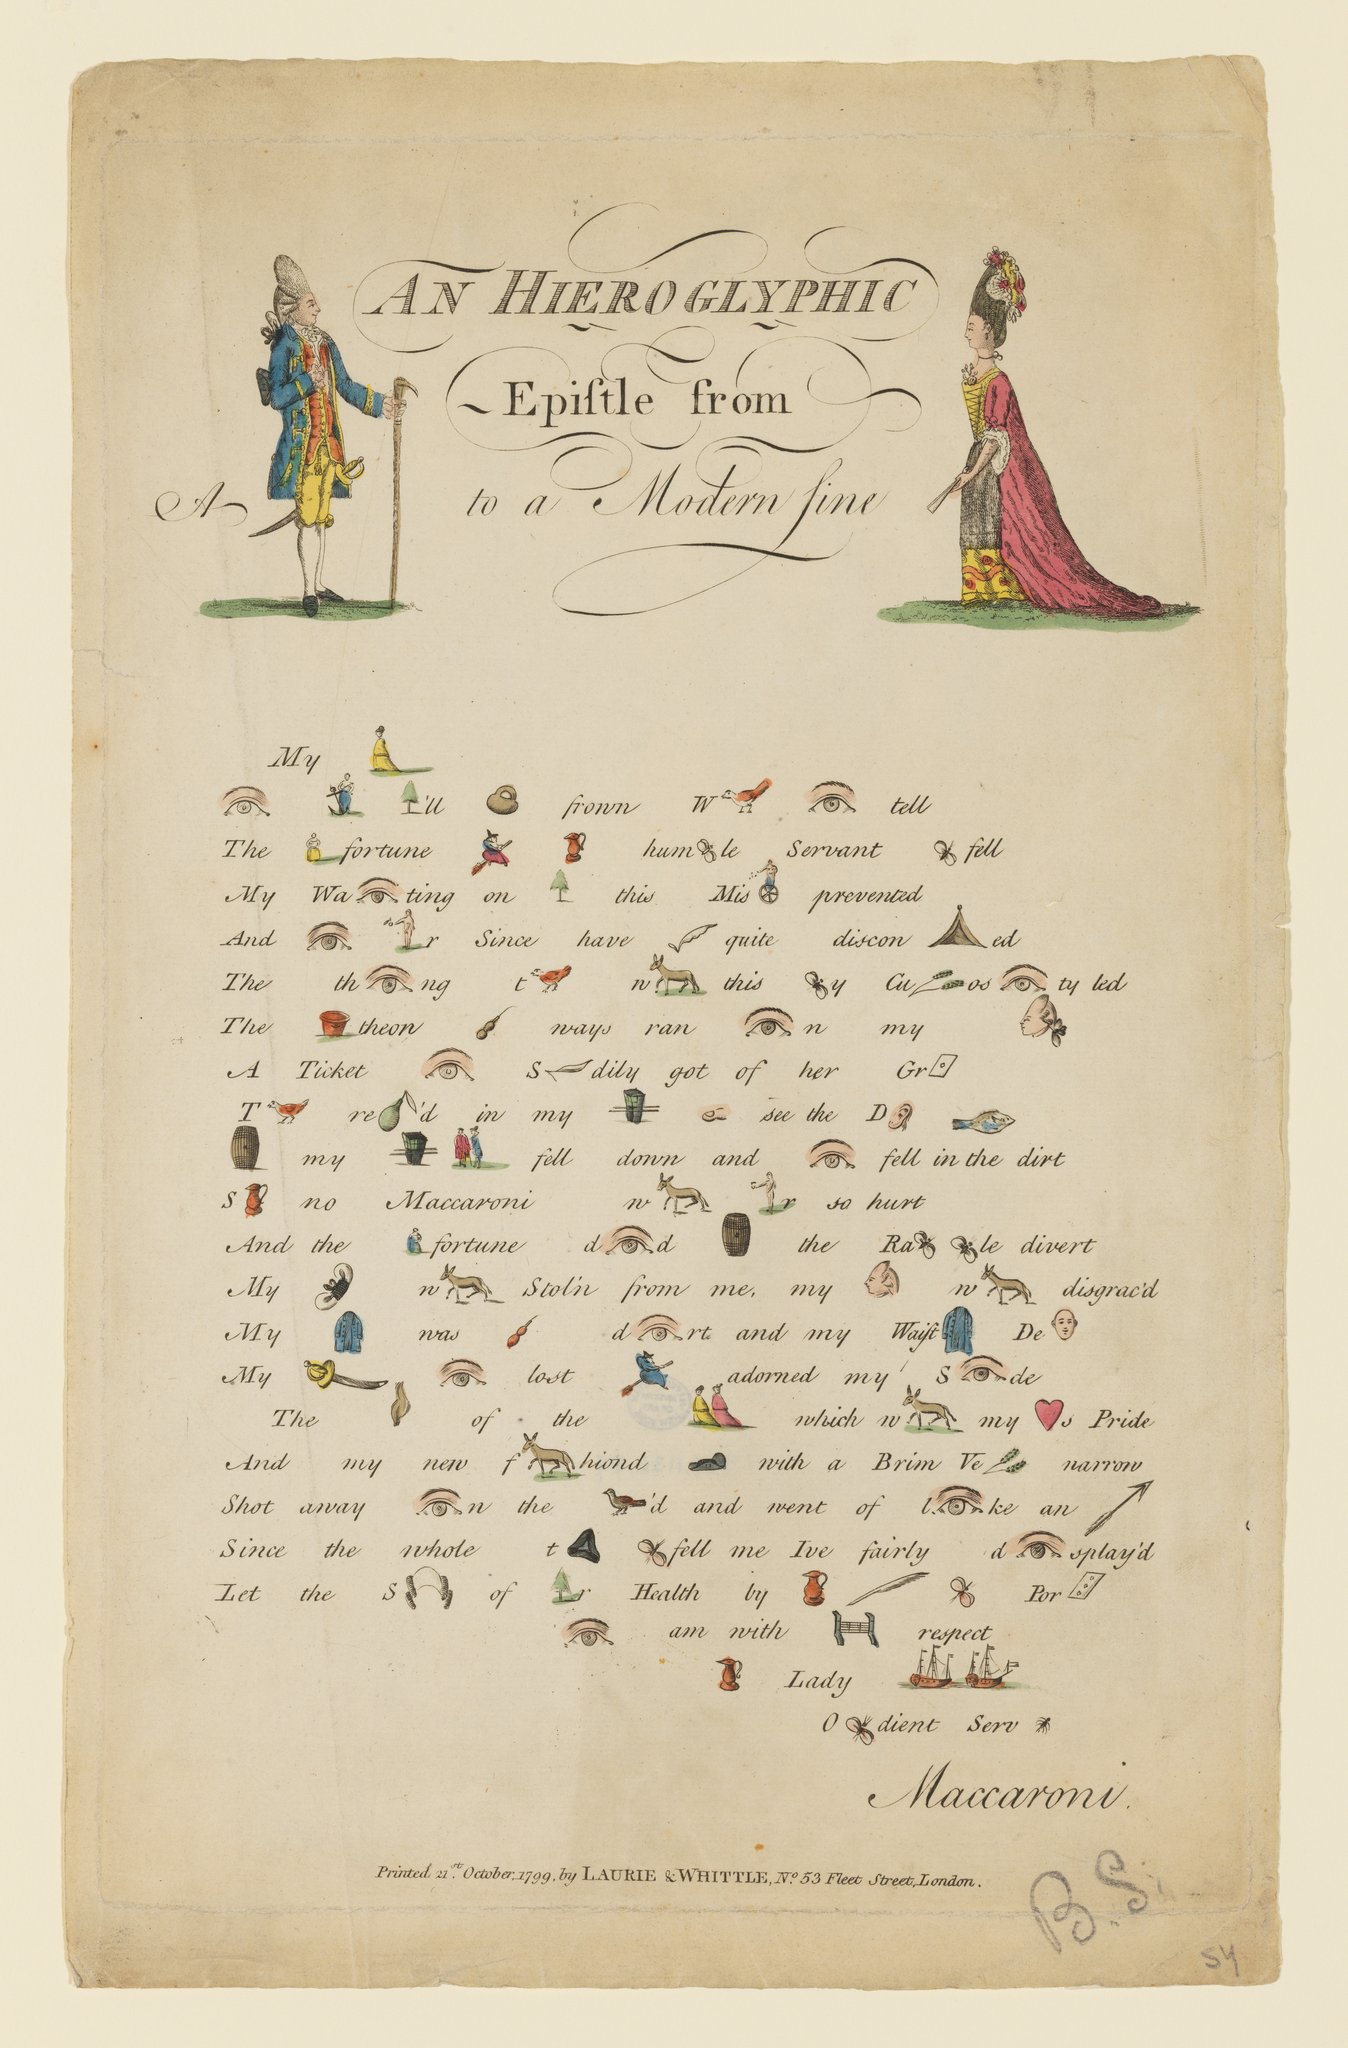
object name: valentine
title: A Hieroglyphic Epistle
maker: whittle & laurie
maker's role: maker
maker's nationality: british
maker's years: 1812-1818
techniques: etching